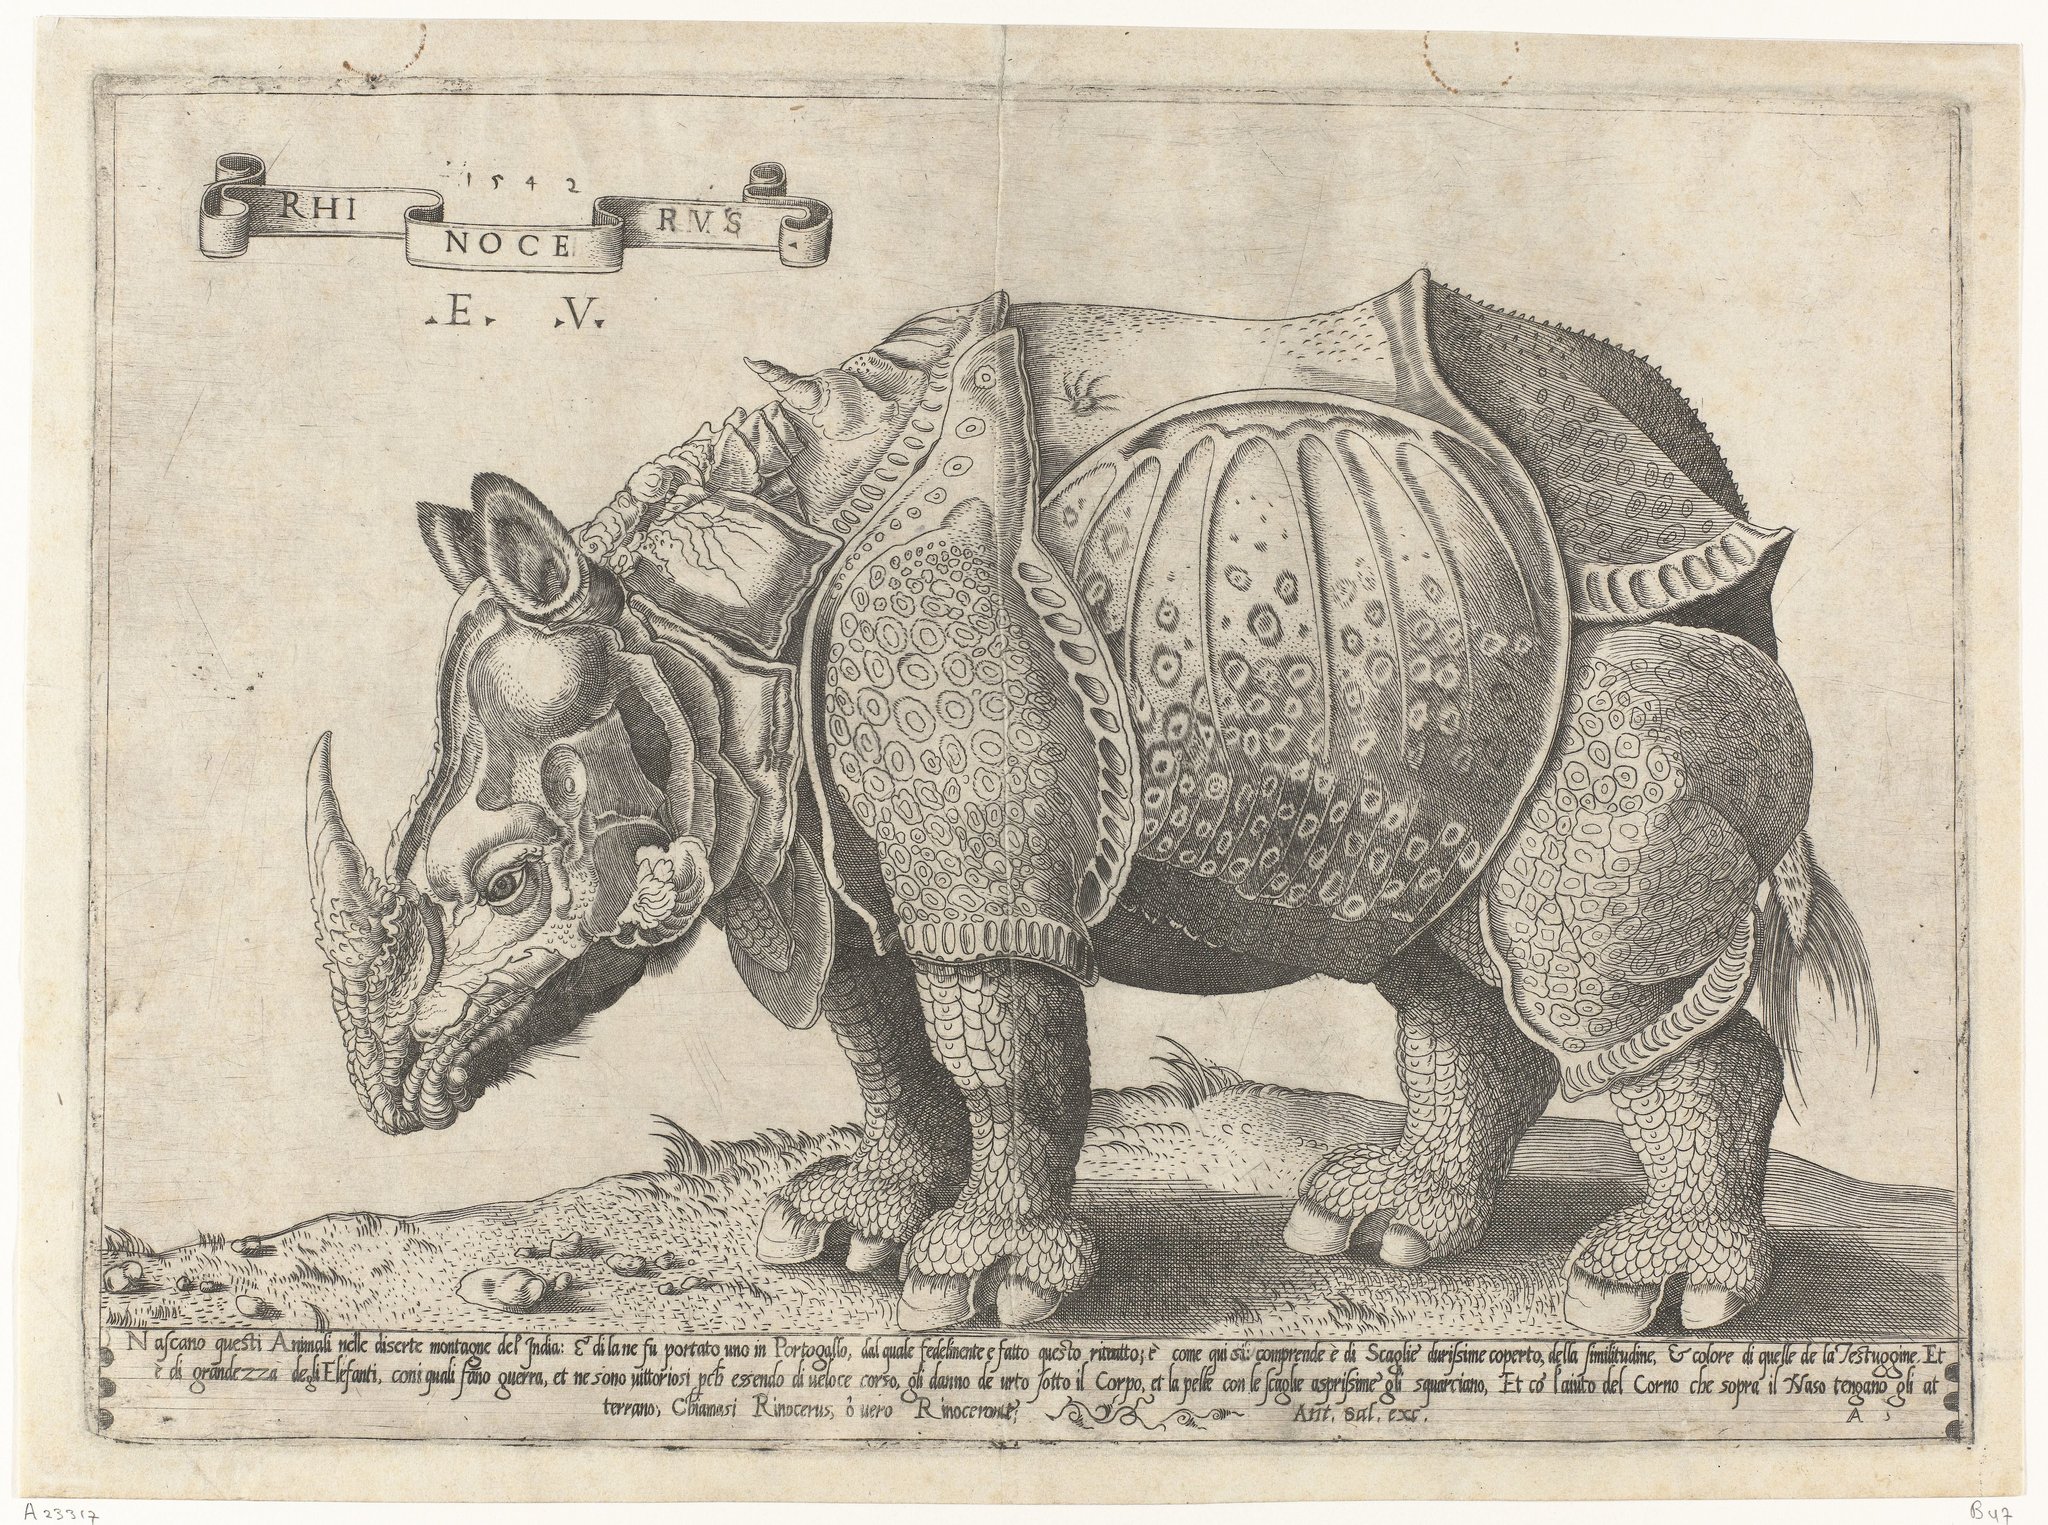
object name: print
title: Neushoorn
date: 1542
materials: paper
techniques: engraving, etching, intaglio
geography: rome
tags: hoofed animals: rhinoceros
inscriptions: collector's mark: Lugt 2228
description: Een neushoorn, staand en naar links gekeerd. Drieregelige tekst in het Italiaans in ondermarge.